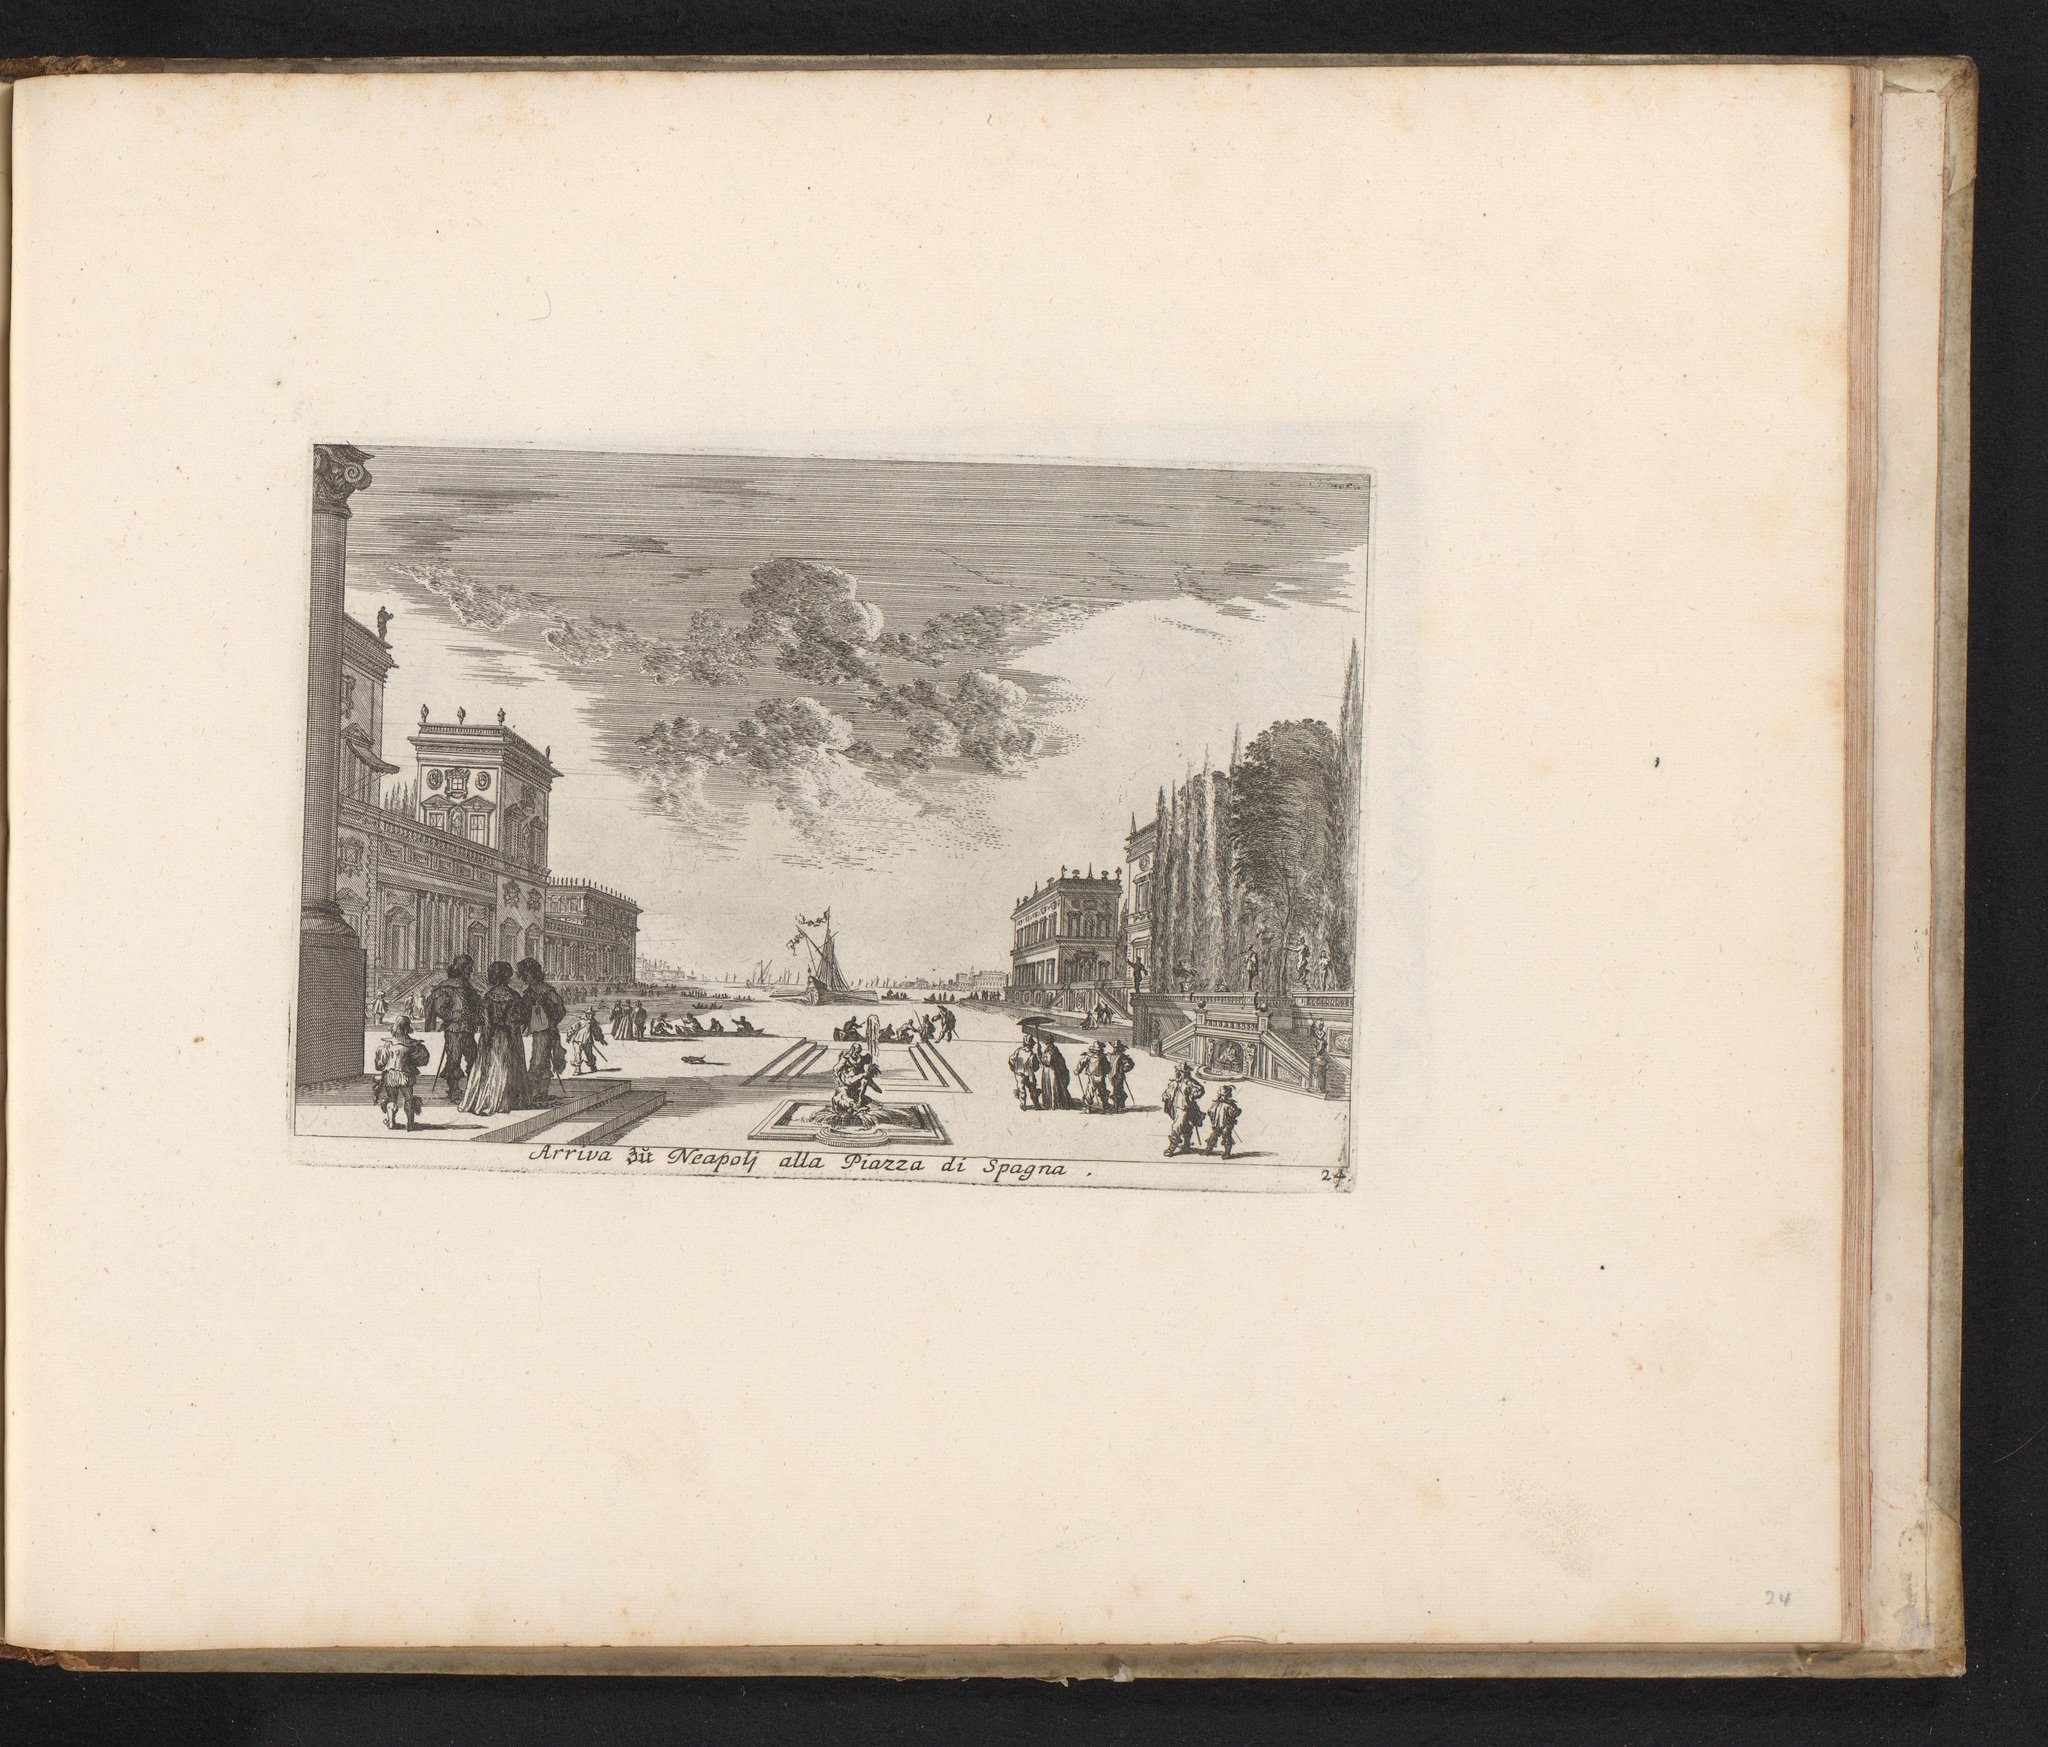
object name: album leaf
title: Werf bij het Piazza di Spagna in Napels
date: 1670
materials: paper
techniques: etching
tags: square, place, circus, etc., pier, quay, wharf (+ four persons or more ~ traffic and transport), hôtel, i.e. small palace in city, naples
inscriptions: collector's mark: Lugt 2228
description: Tekst in het Duits in de ondermarge. Rechtsonder genummerd: 24. Prent maakt deel uit van een album.